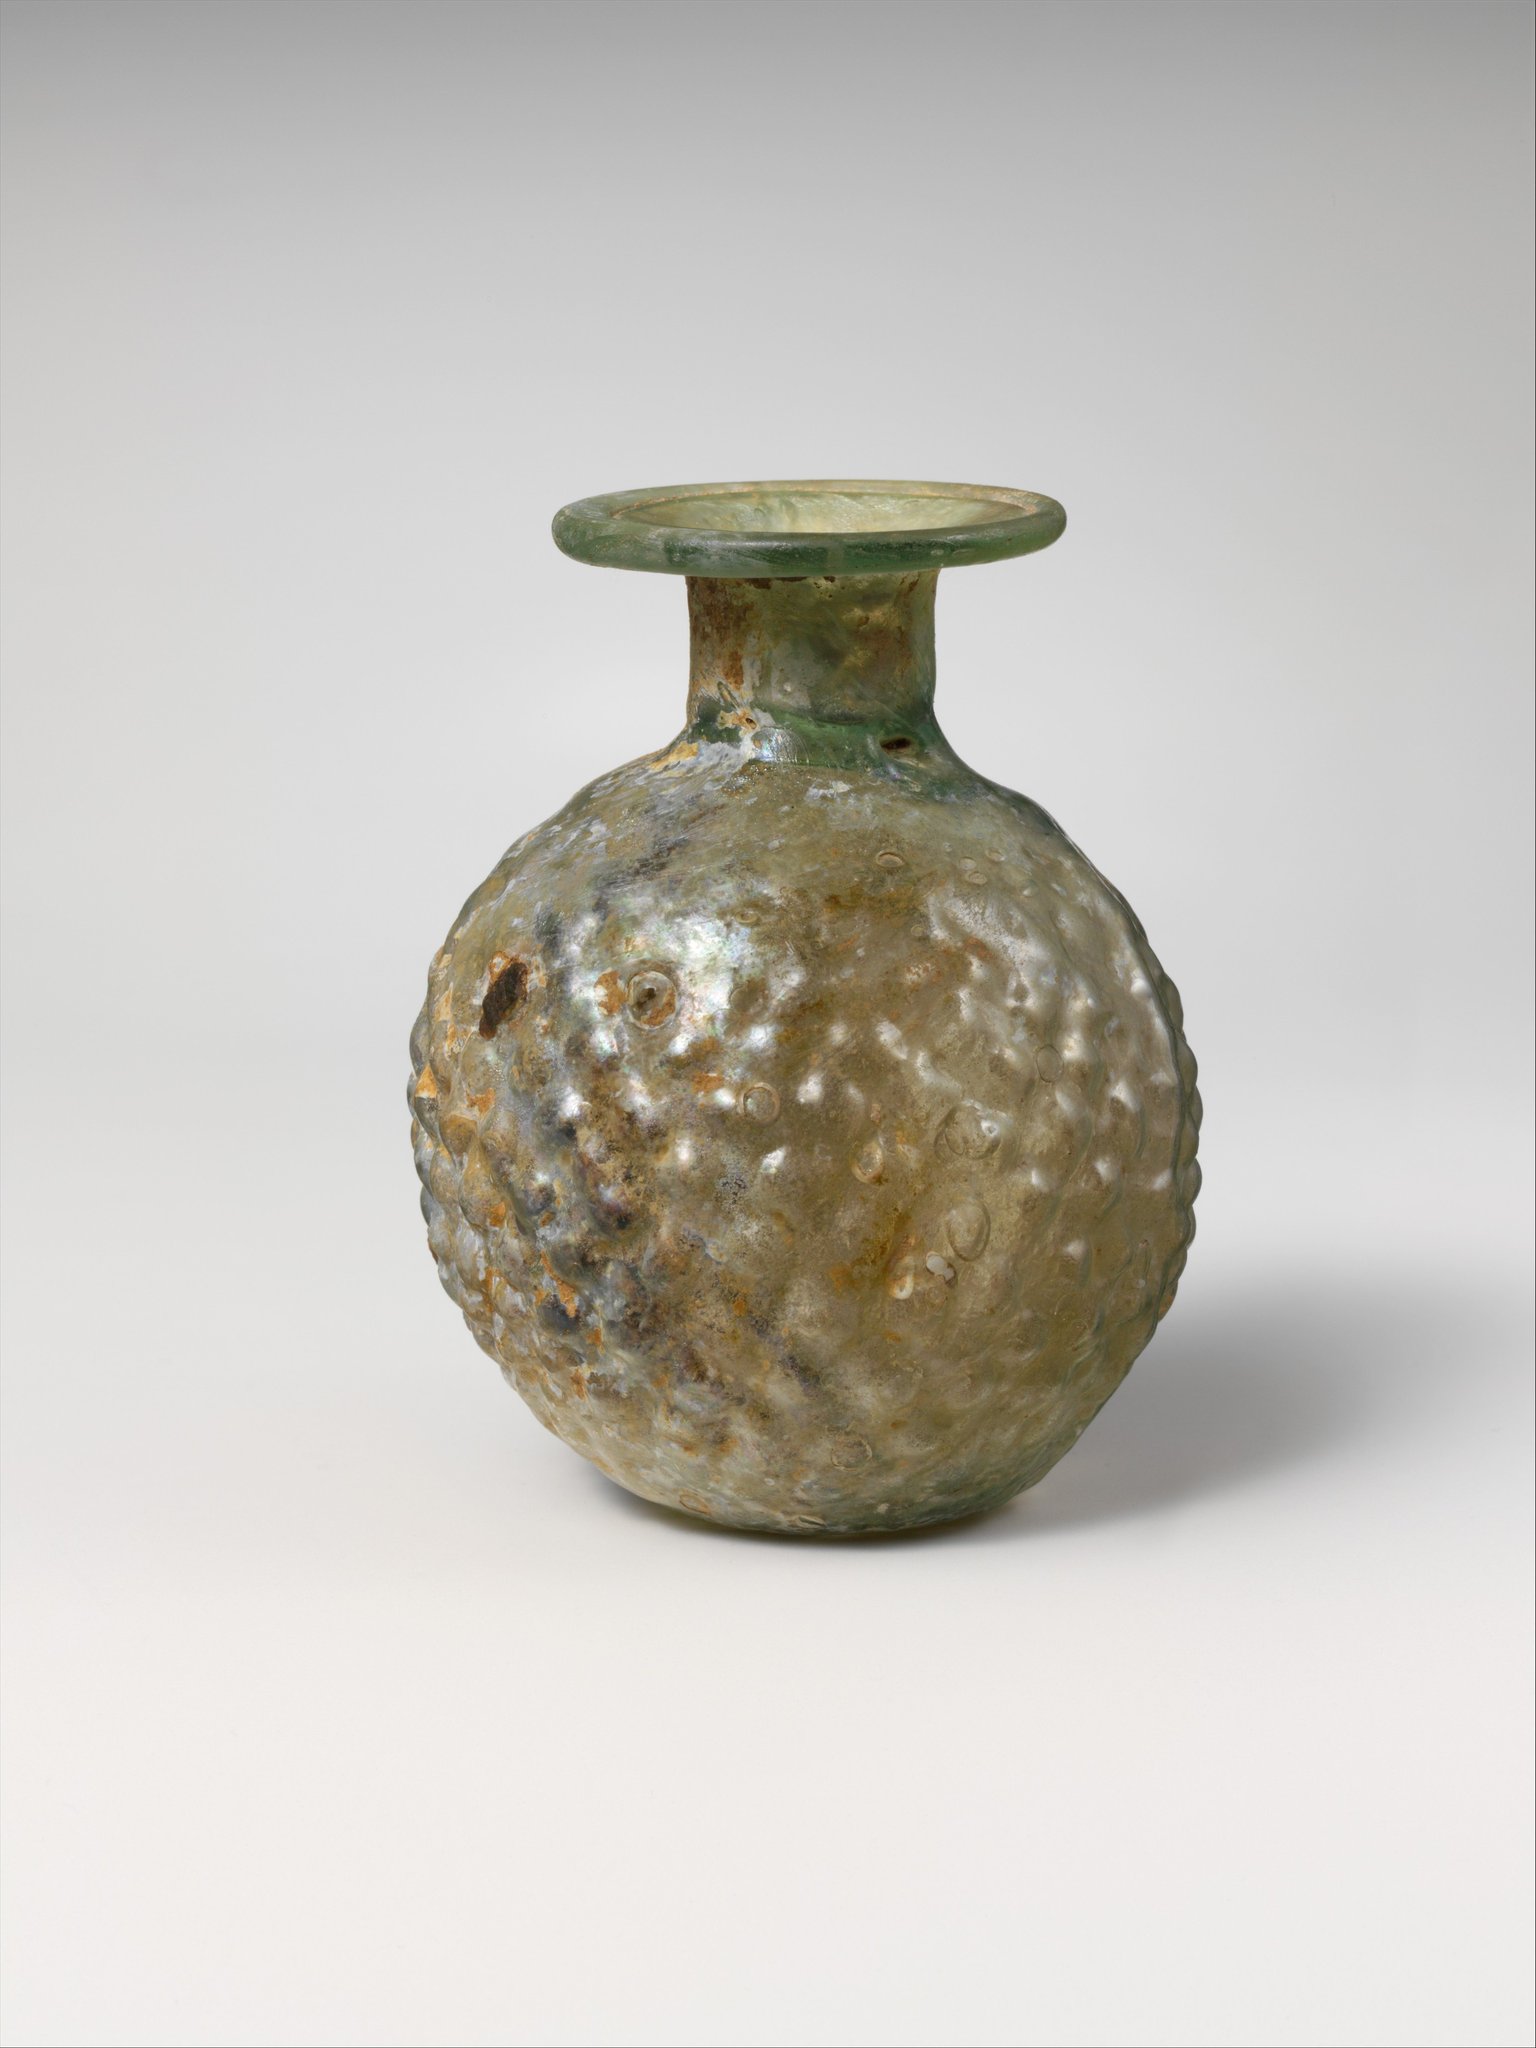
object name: sprinkler flask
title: Glass sprinkler flask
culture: roman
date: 301-400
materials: glass